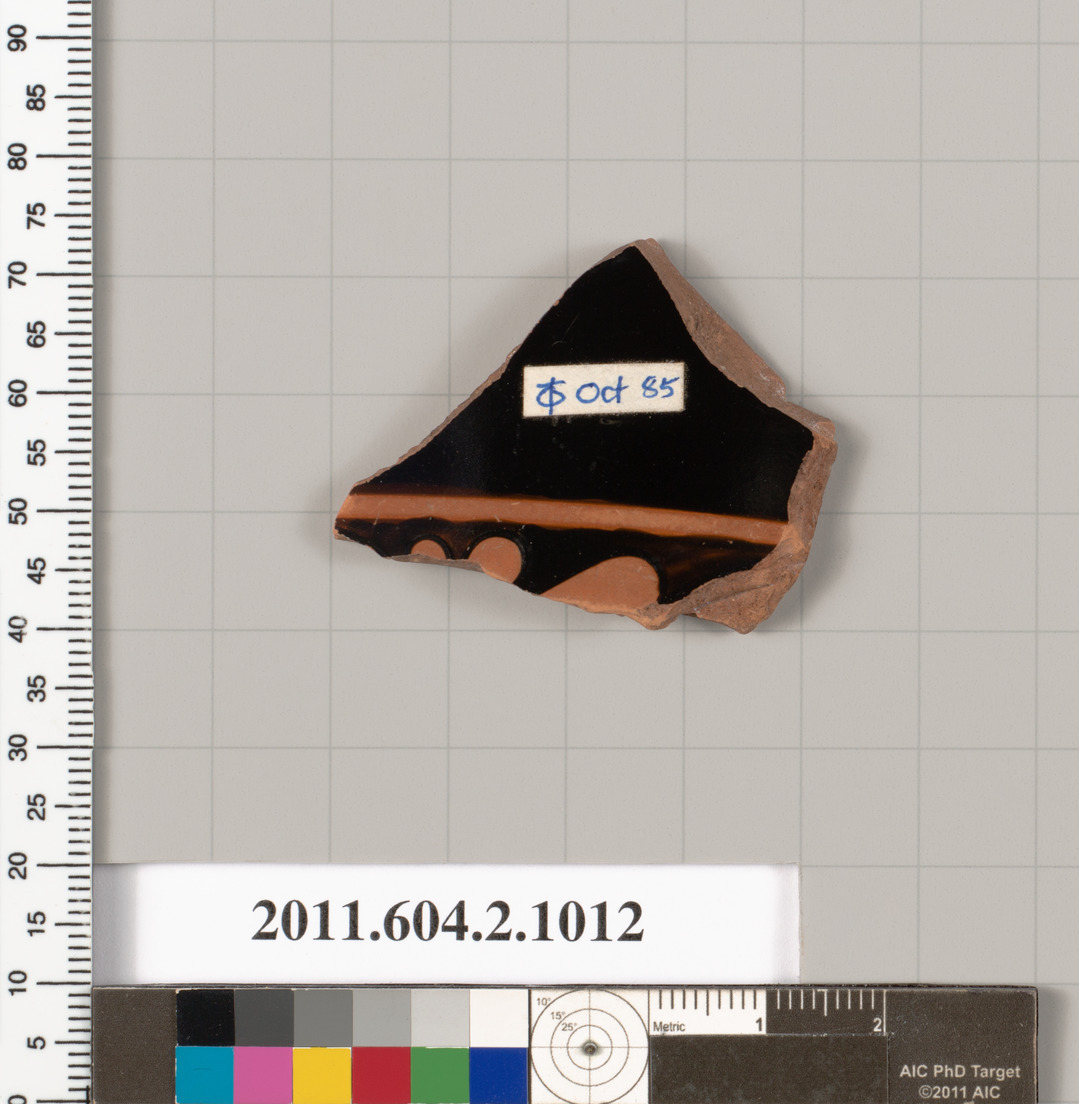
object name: oinochoe fragment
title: Terracotta fragment of an oinochoe (jug)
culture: greek, attic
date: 467-435 BCE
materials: terracotta